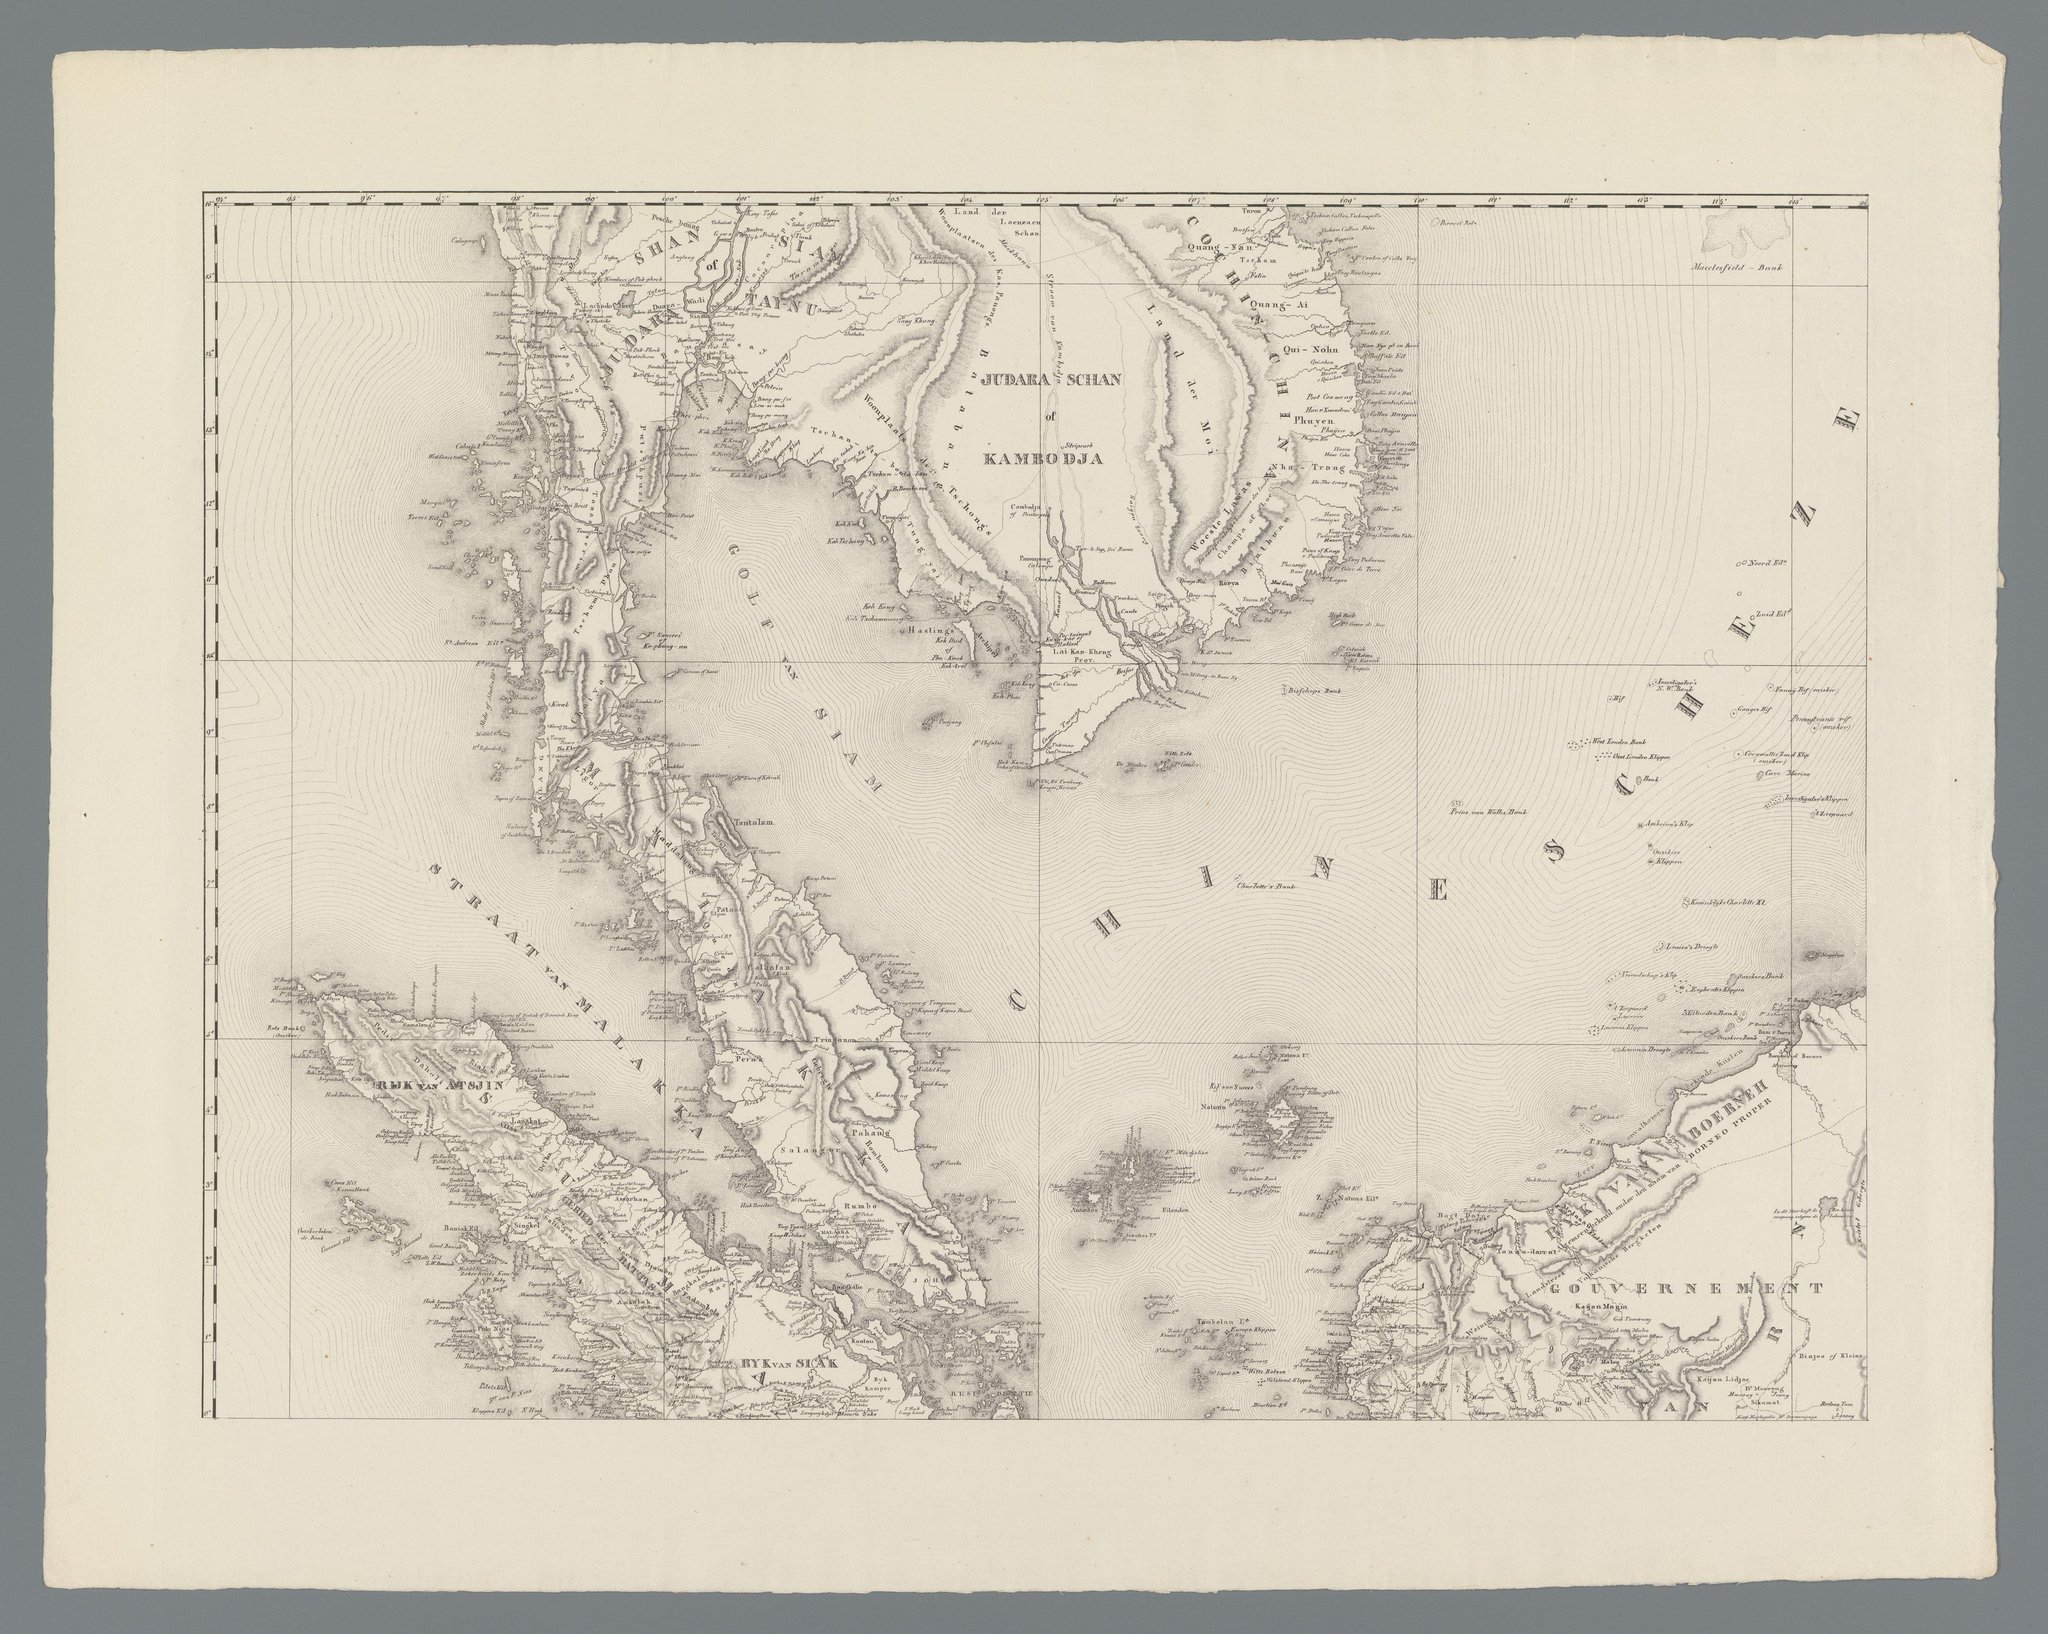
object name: print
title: Kaart van Nederlands-Oost-Indië, deel linksboven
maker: franciscus josephus ensinck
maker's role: print maker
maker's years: 1806-1883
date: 1847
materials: paper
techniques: lithograph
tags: maps of separate countries or regions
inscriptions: collector's mark: Lugt 2228, collector's mark: Lugt 2166, collector's mark: Lugt 2760